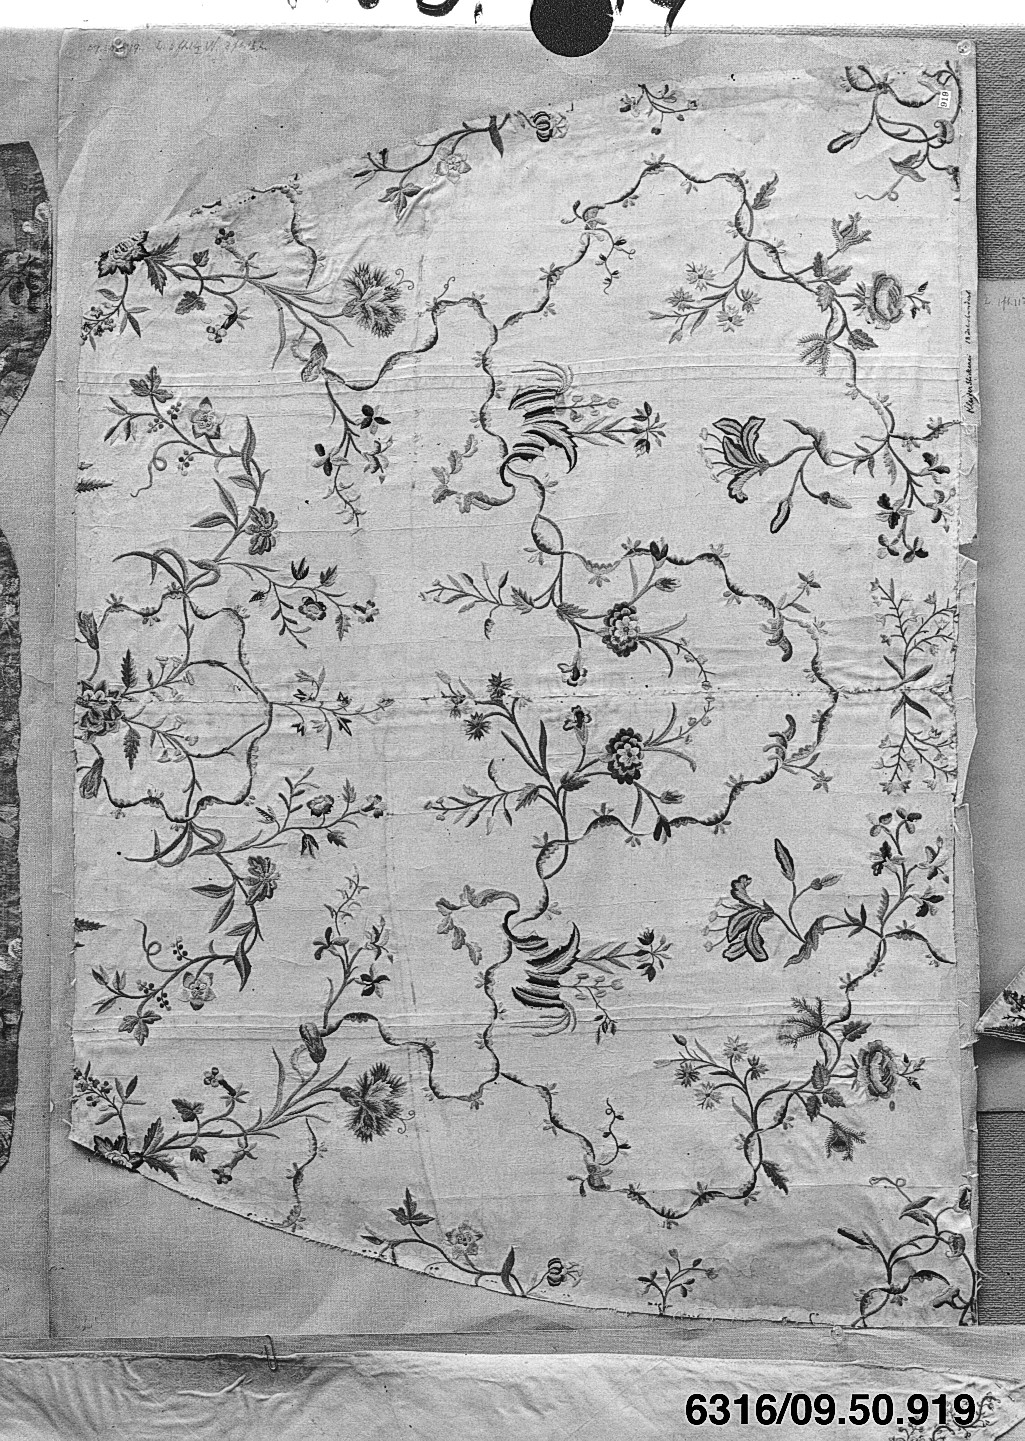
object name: fragment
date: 1701-1800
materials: silk, thread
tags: leaves